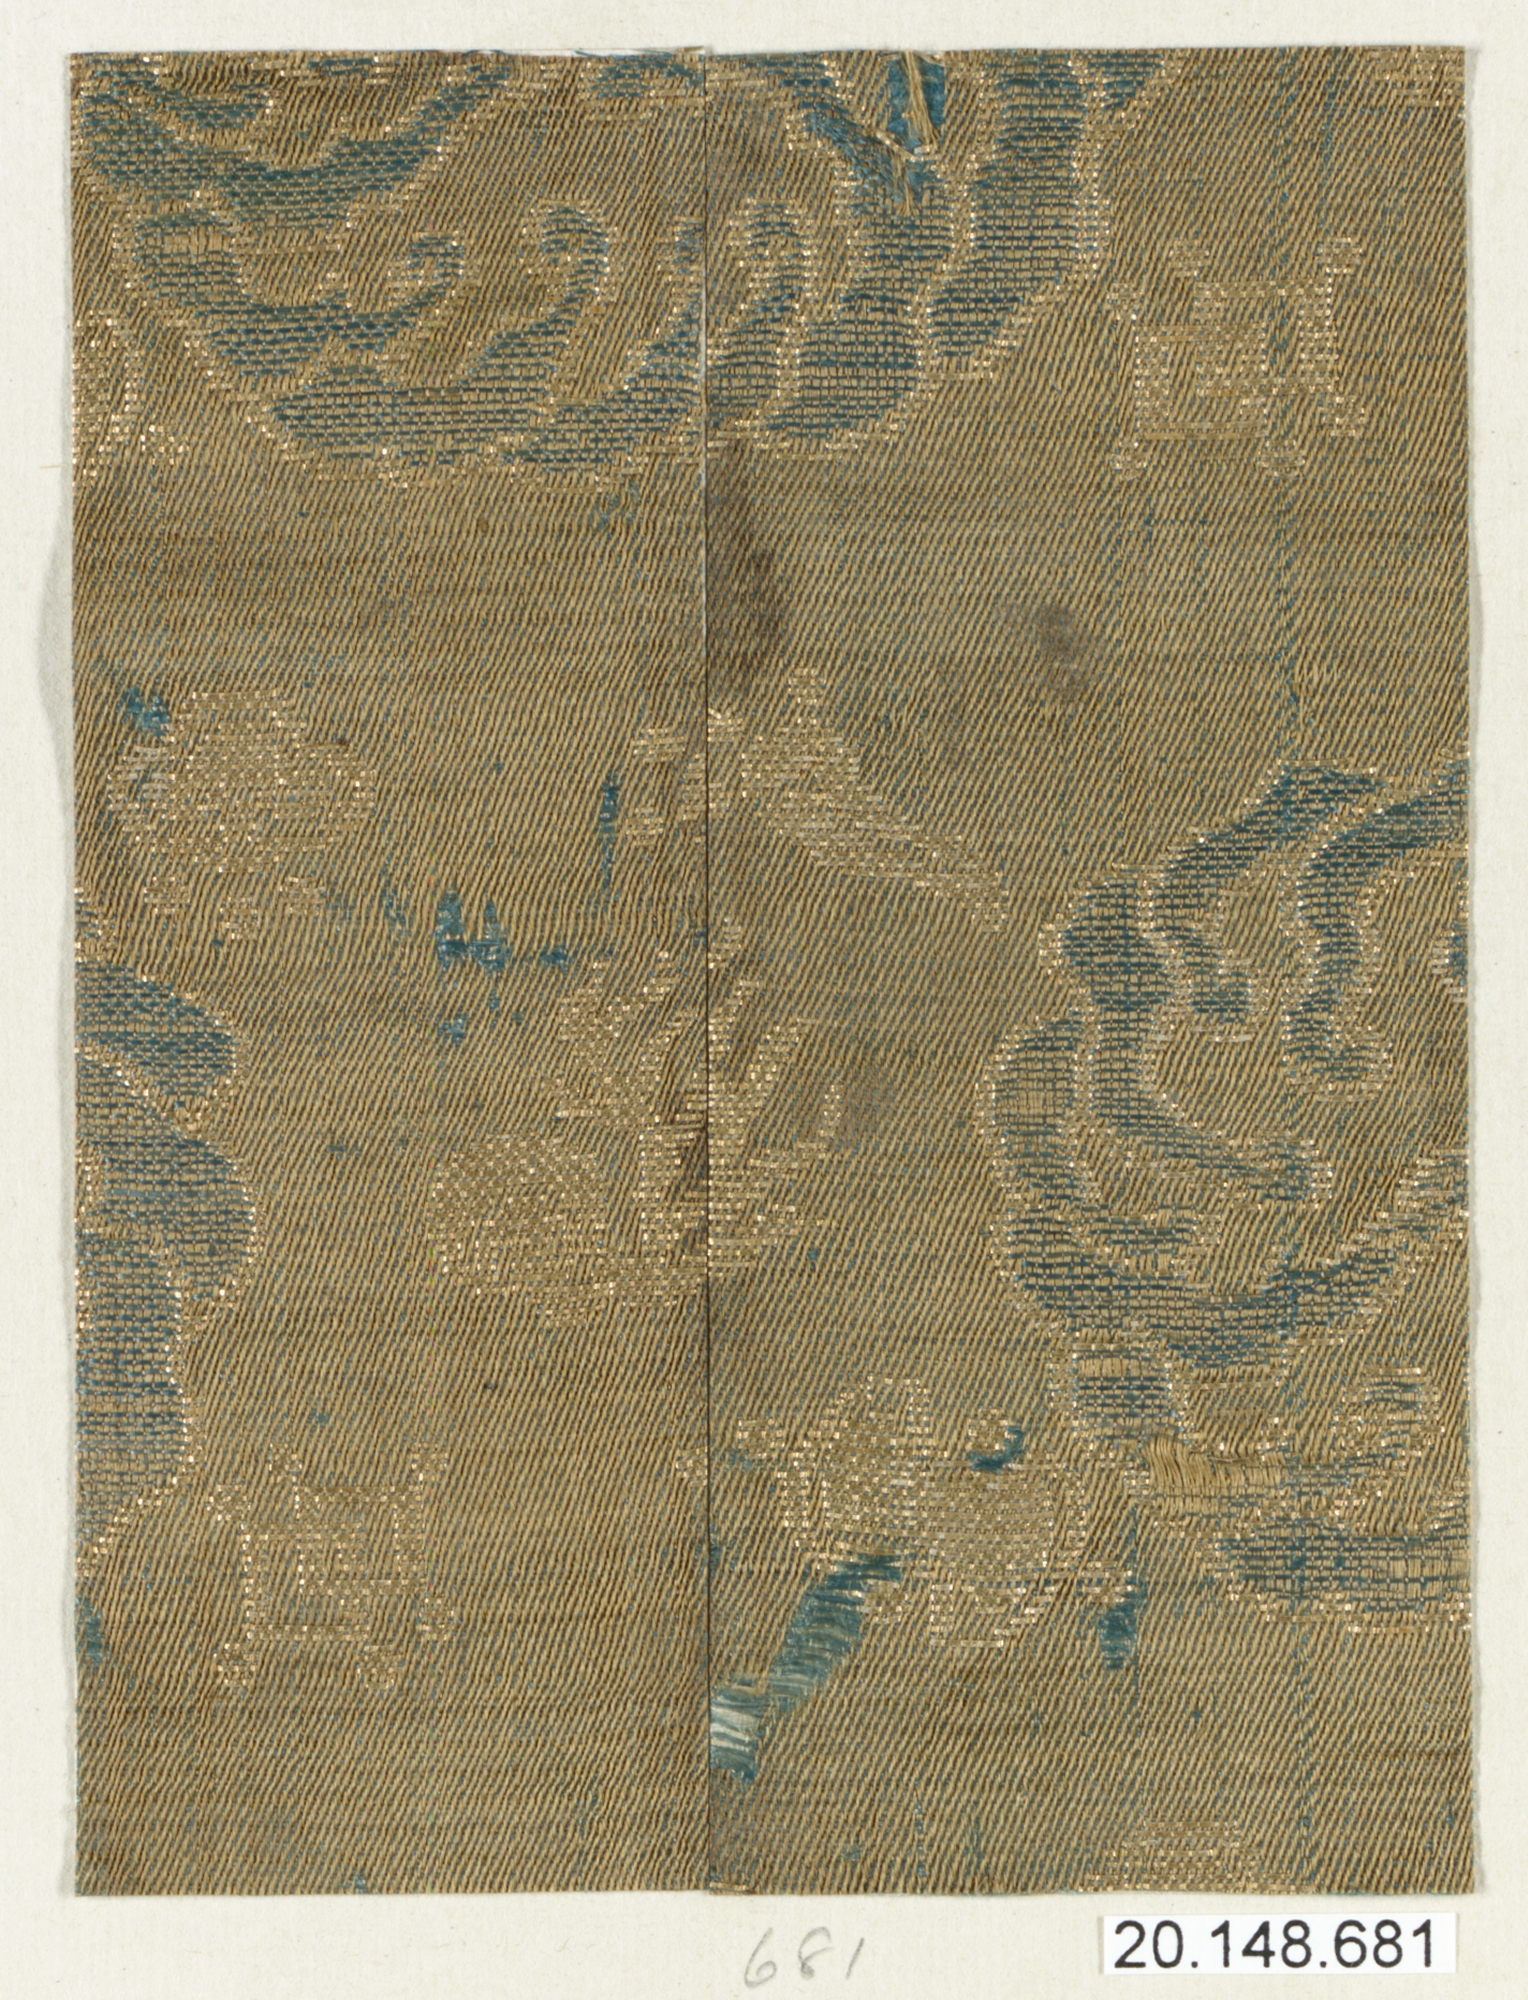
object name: piece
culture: japanese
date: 1701-1800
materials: silk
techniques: compound weave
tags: flowers